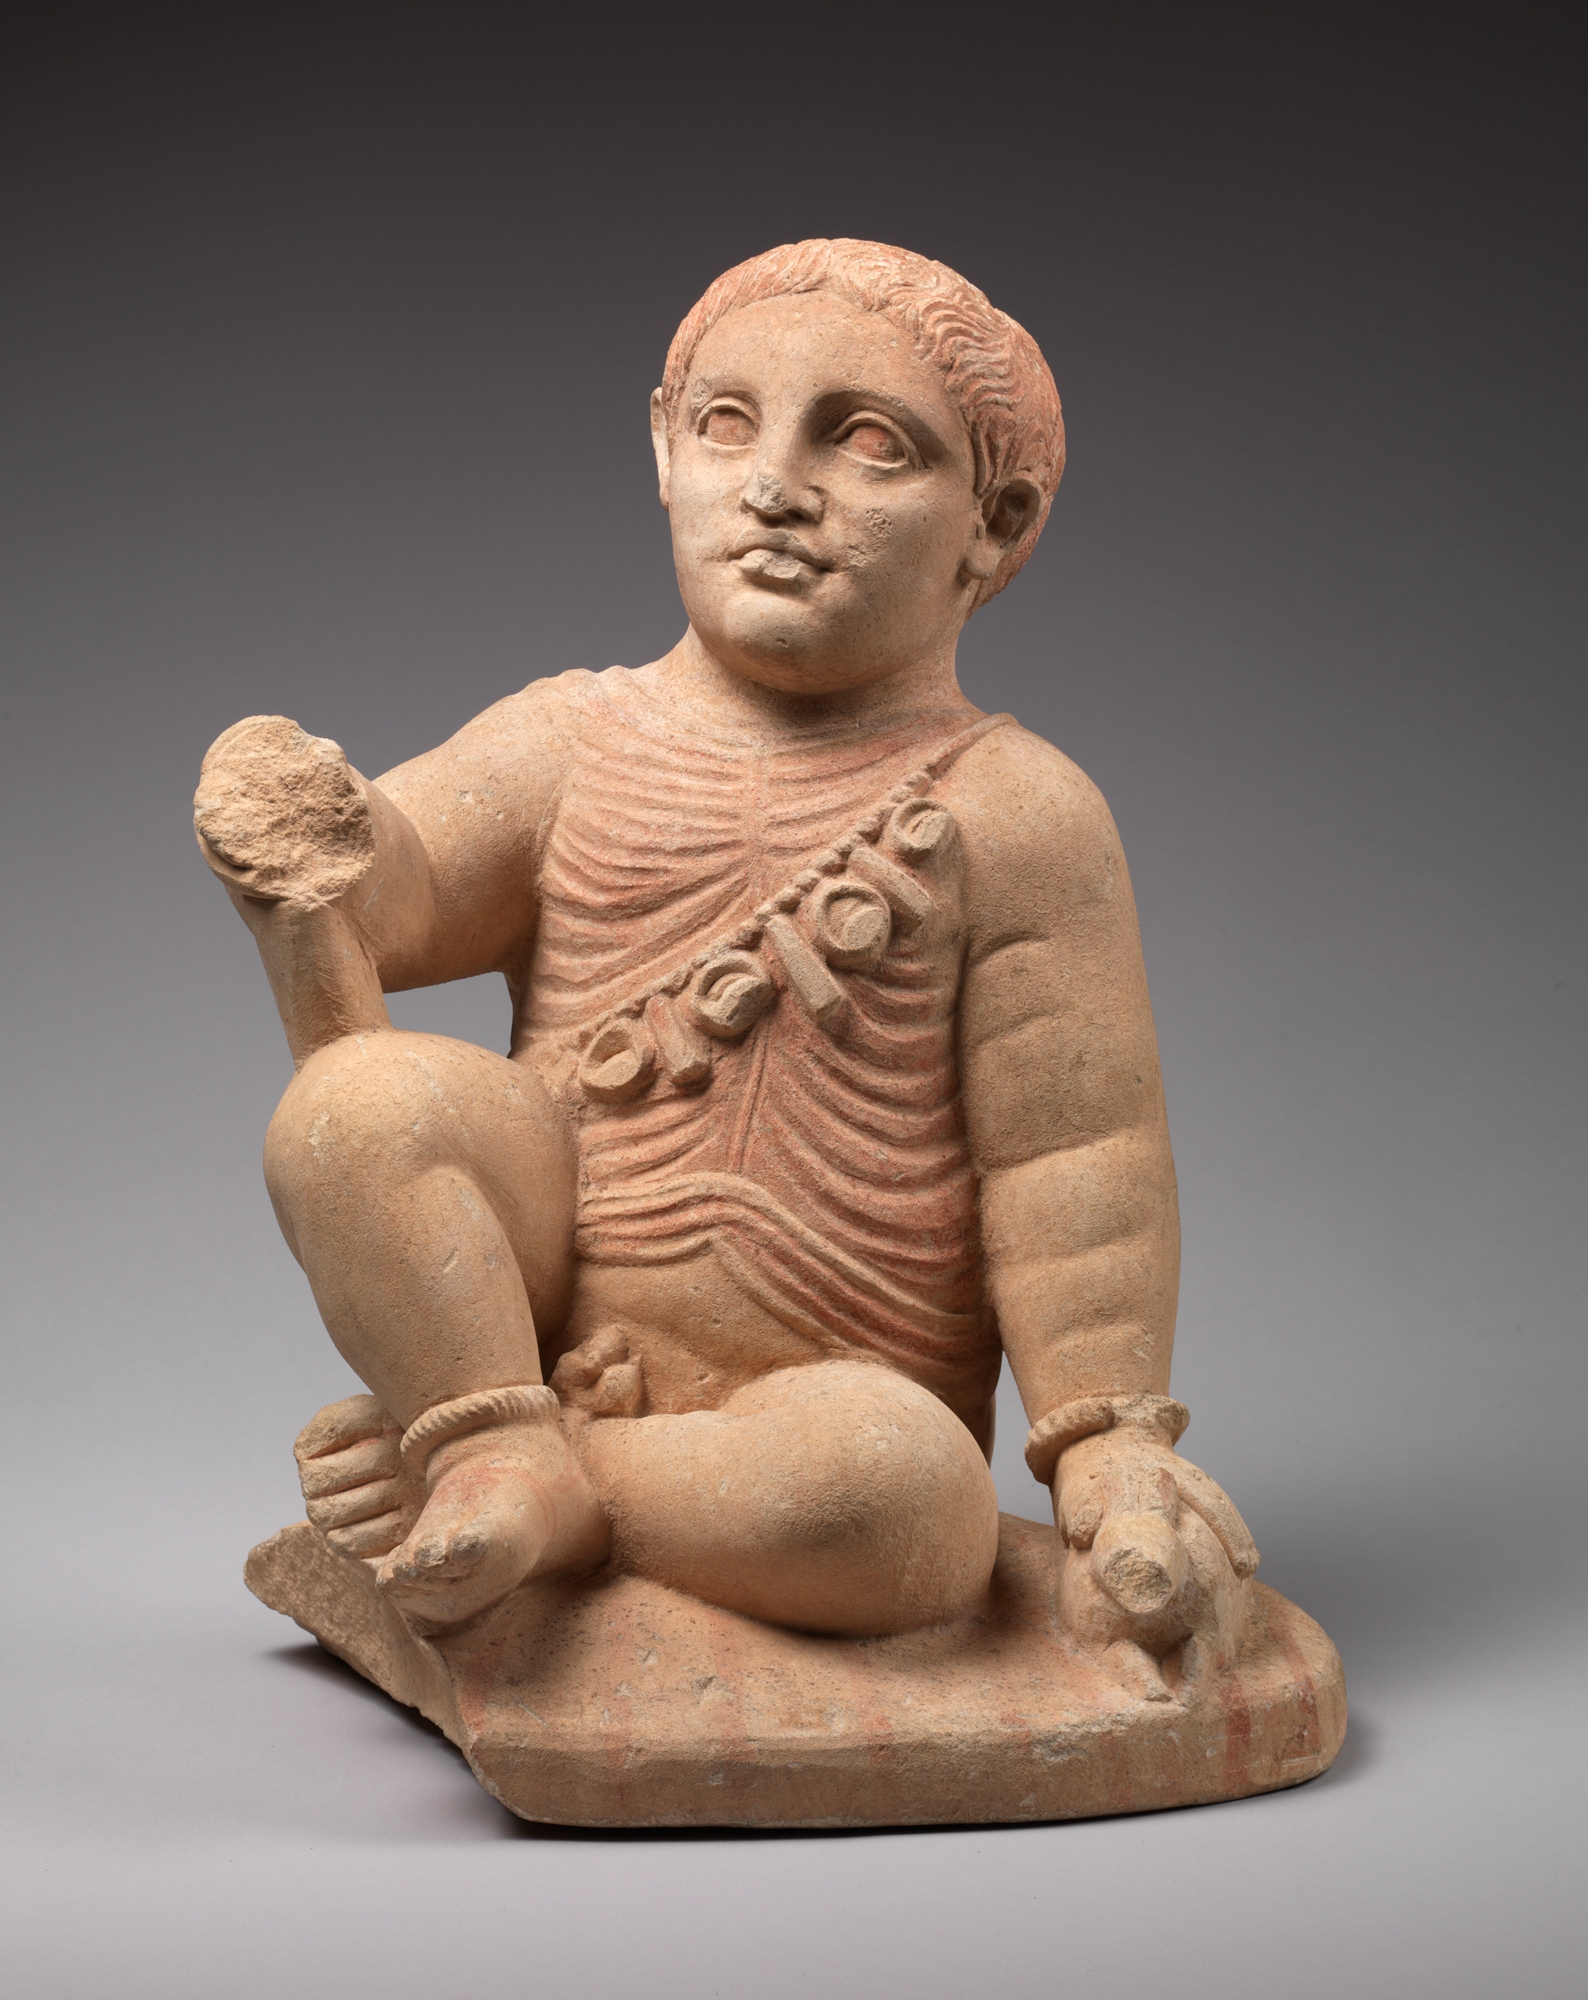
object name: statuette of a temple boy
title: Limestone statuette of a temple boy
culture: cypriot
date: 400-301 BCE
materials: limestone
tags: boys,rabbits